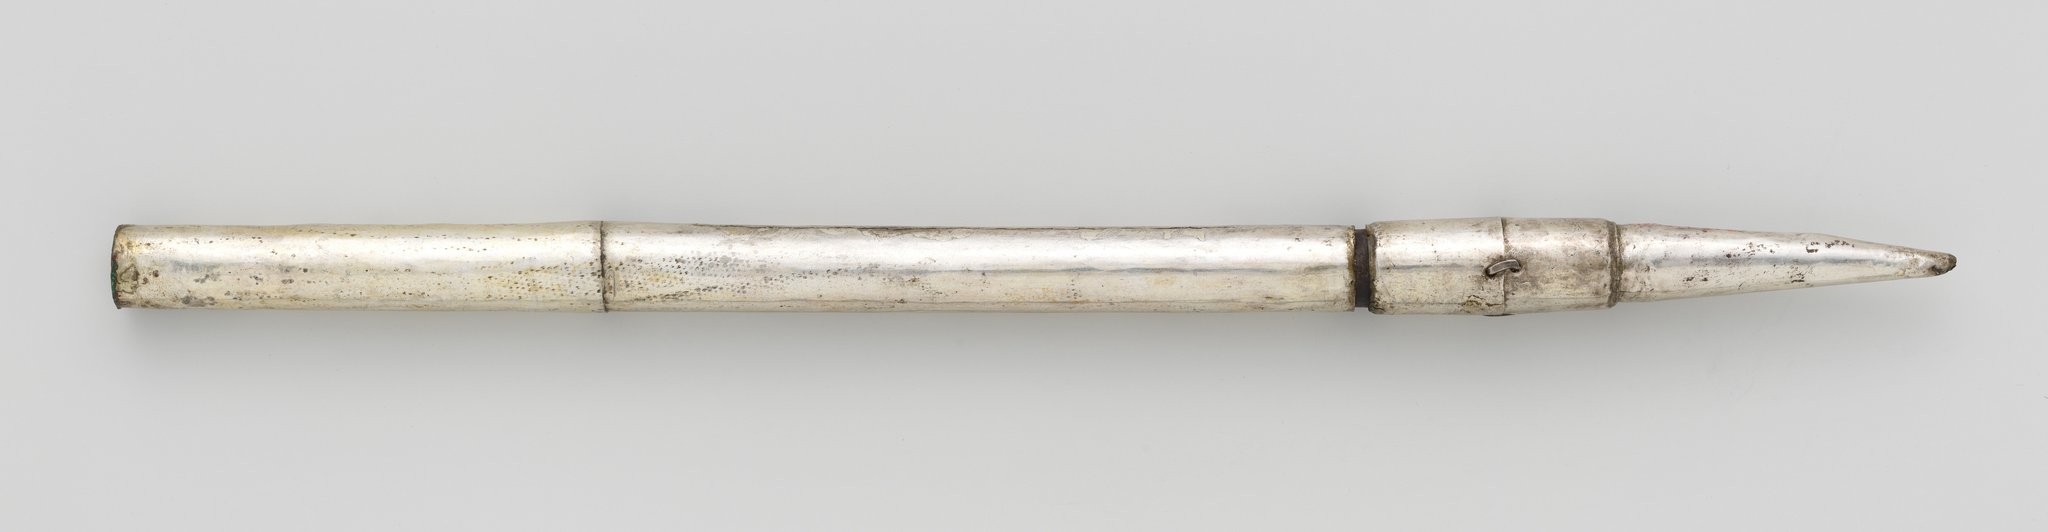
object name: stick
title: Digging stick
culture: chancay or chimú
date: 1101-1500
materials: silver, wood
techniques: hammering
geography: peru